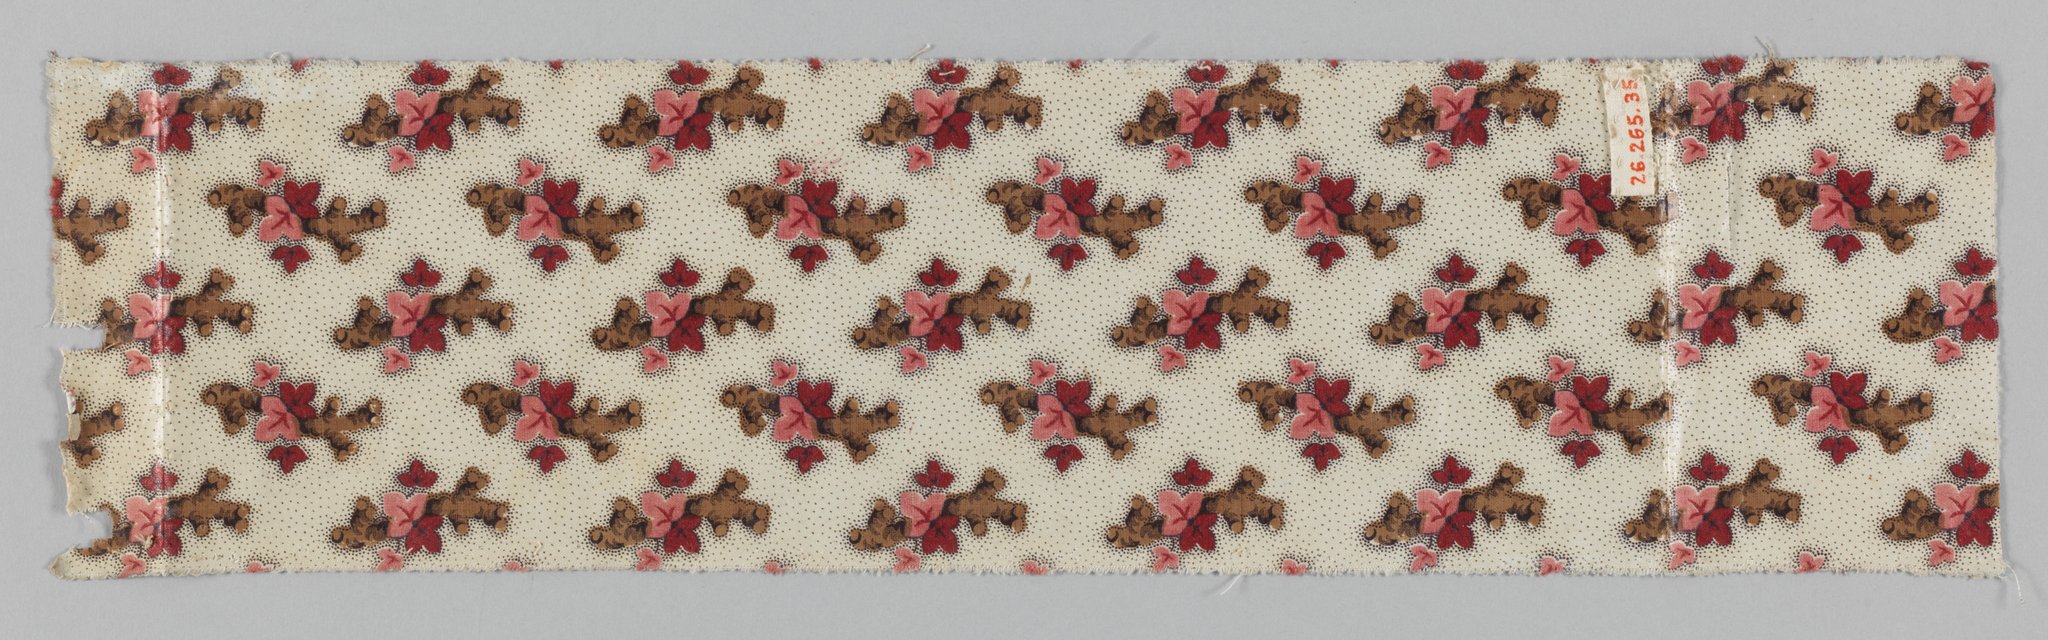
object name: piece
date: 1850-1855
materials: cotton